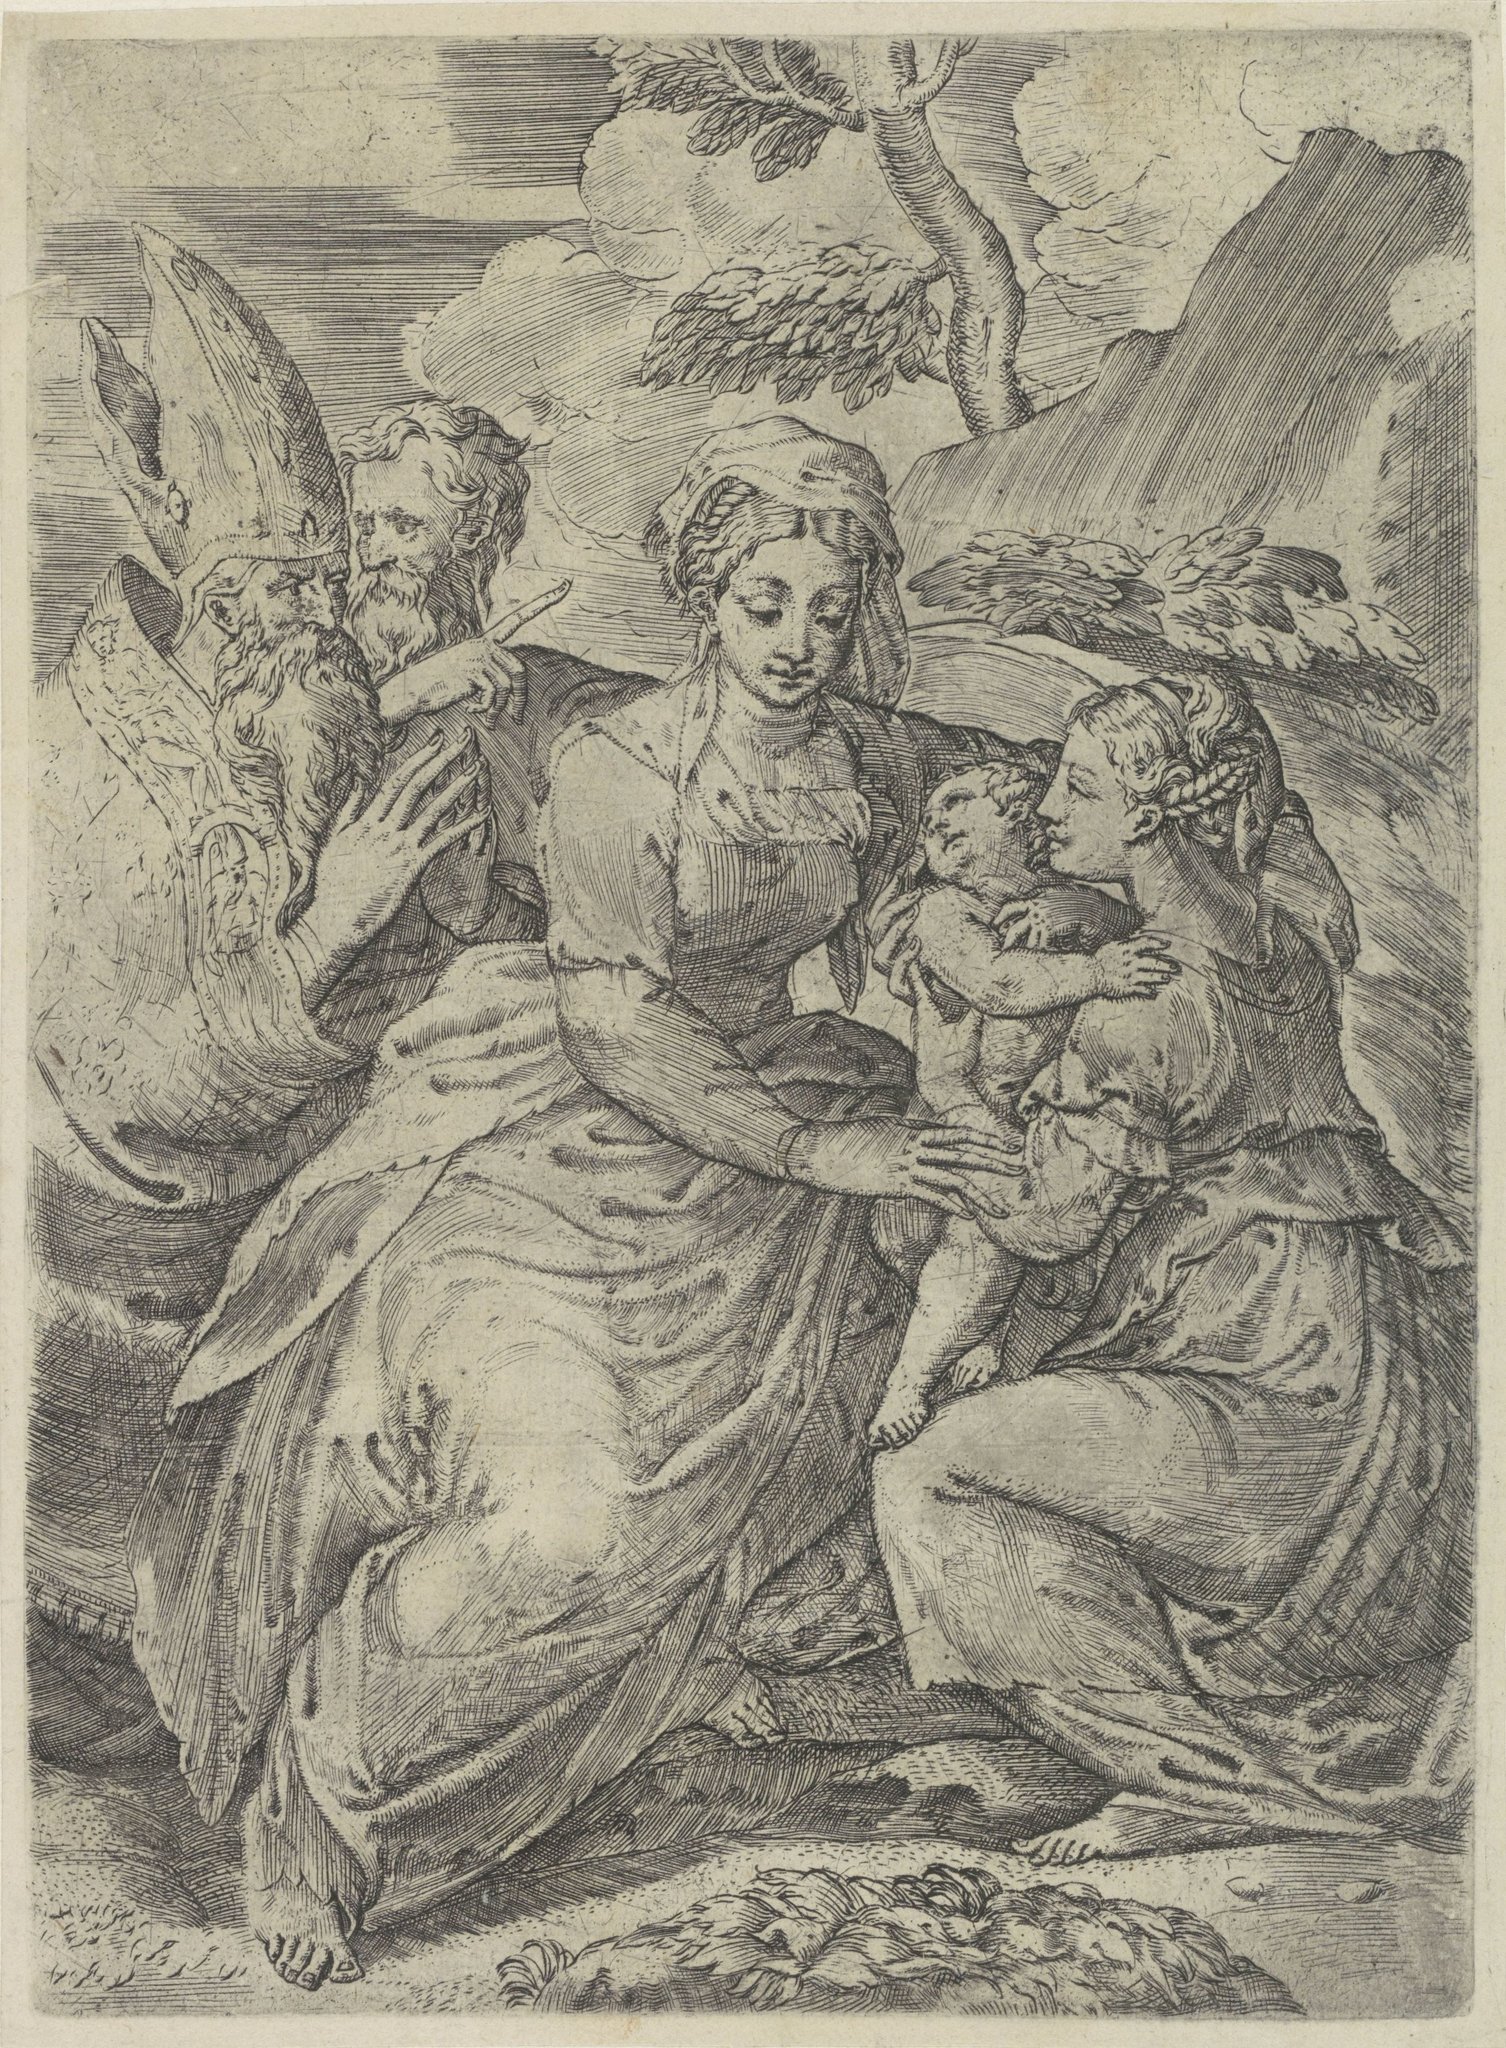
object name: print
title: Madonna met kind en heiligen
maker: battista angolo del moro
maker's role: print maker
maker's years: 1514-1575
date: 1524-1575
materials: paper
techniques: etching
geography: verona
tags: madonna accompanied by saint(s), madonna (i.e. mary with the christ-child) accompanied or surrounded by others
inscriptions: collector's mark: Lugt 240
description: Madonna met het Christuskind en heiligen. Op de achtergrond staat Jozef die wijst met zin rechterhand.